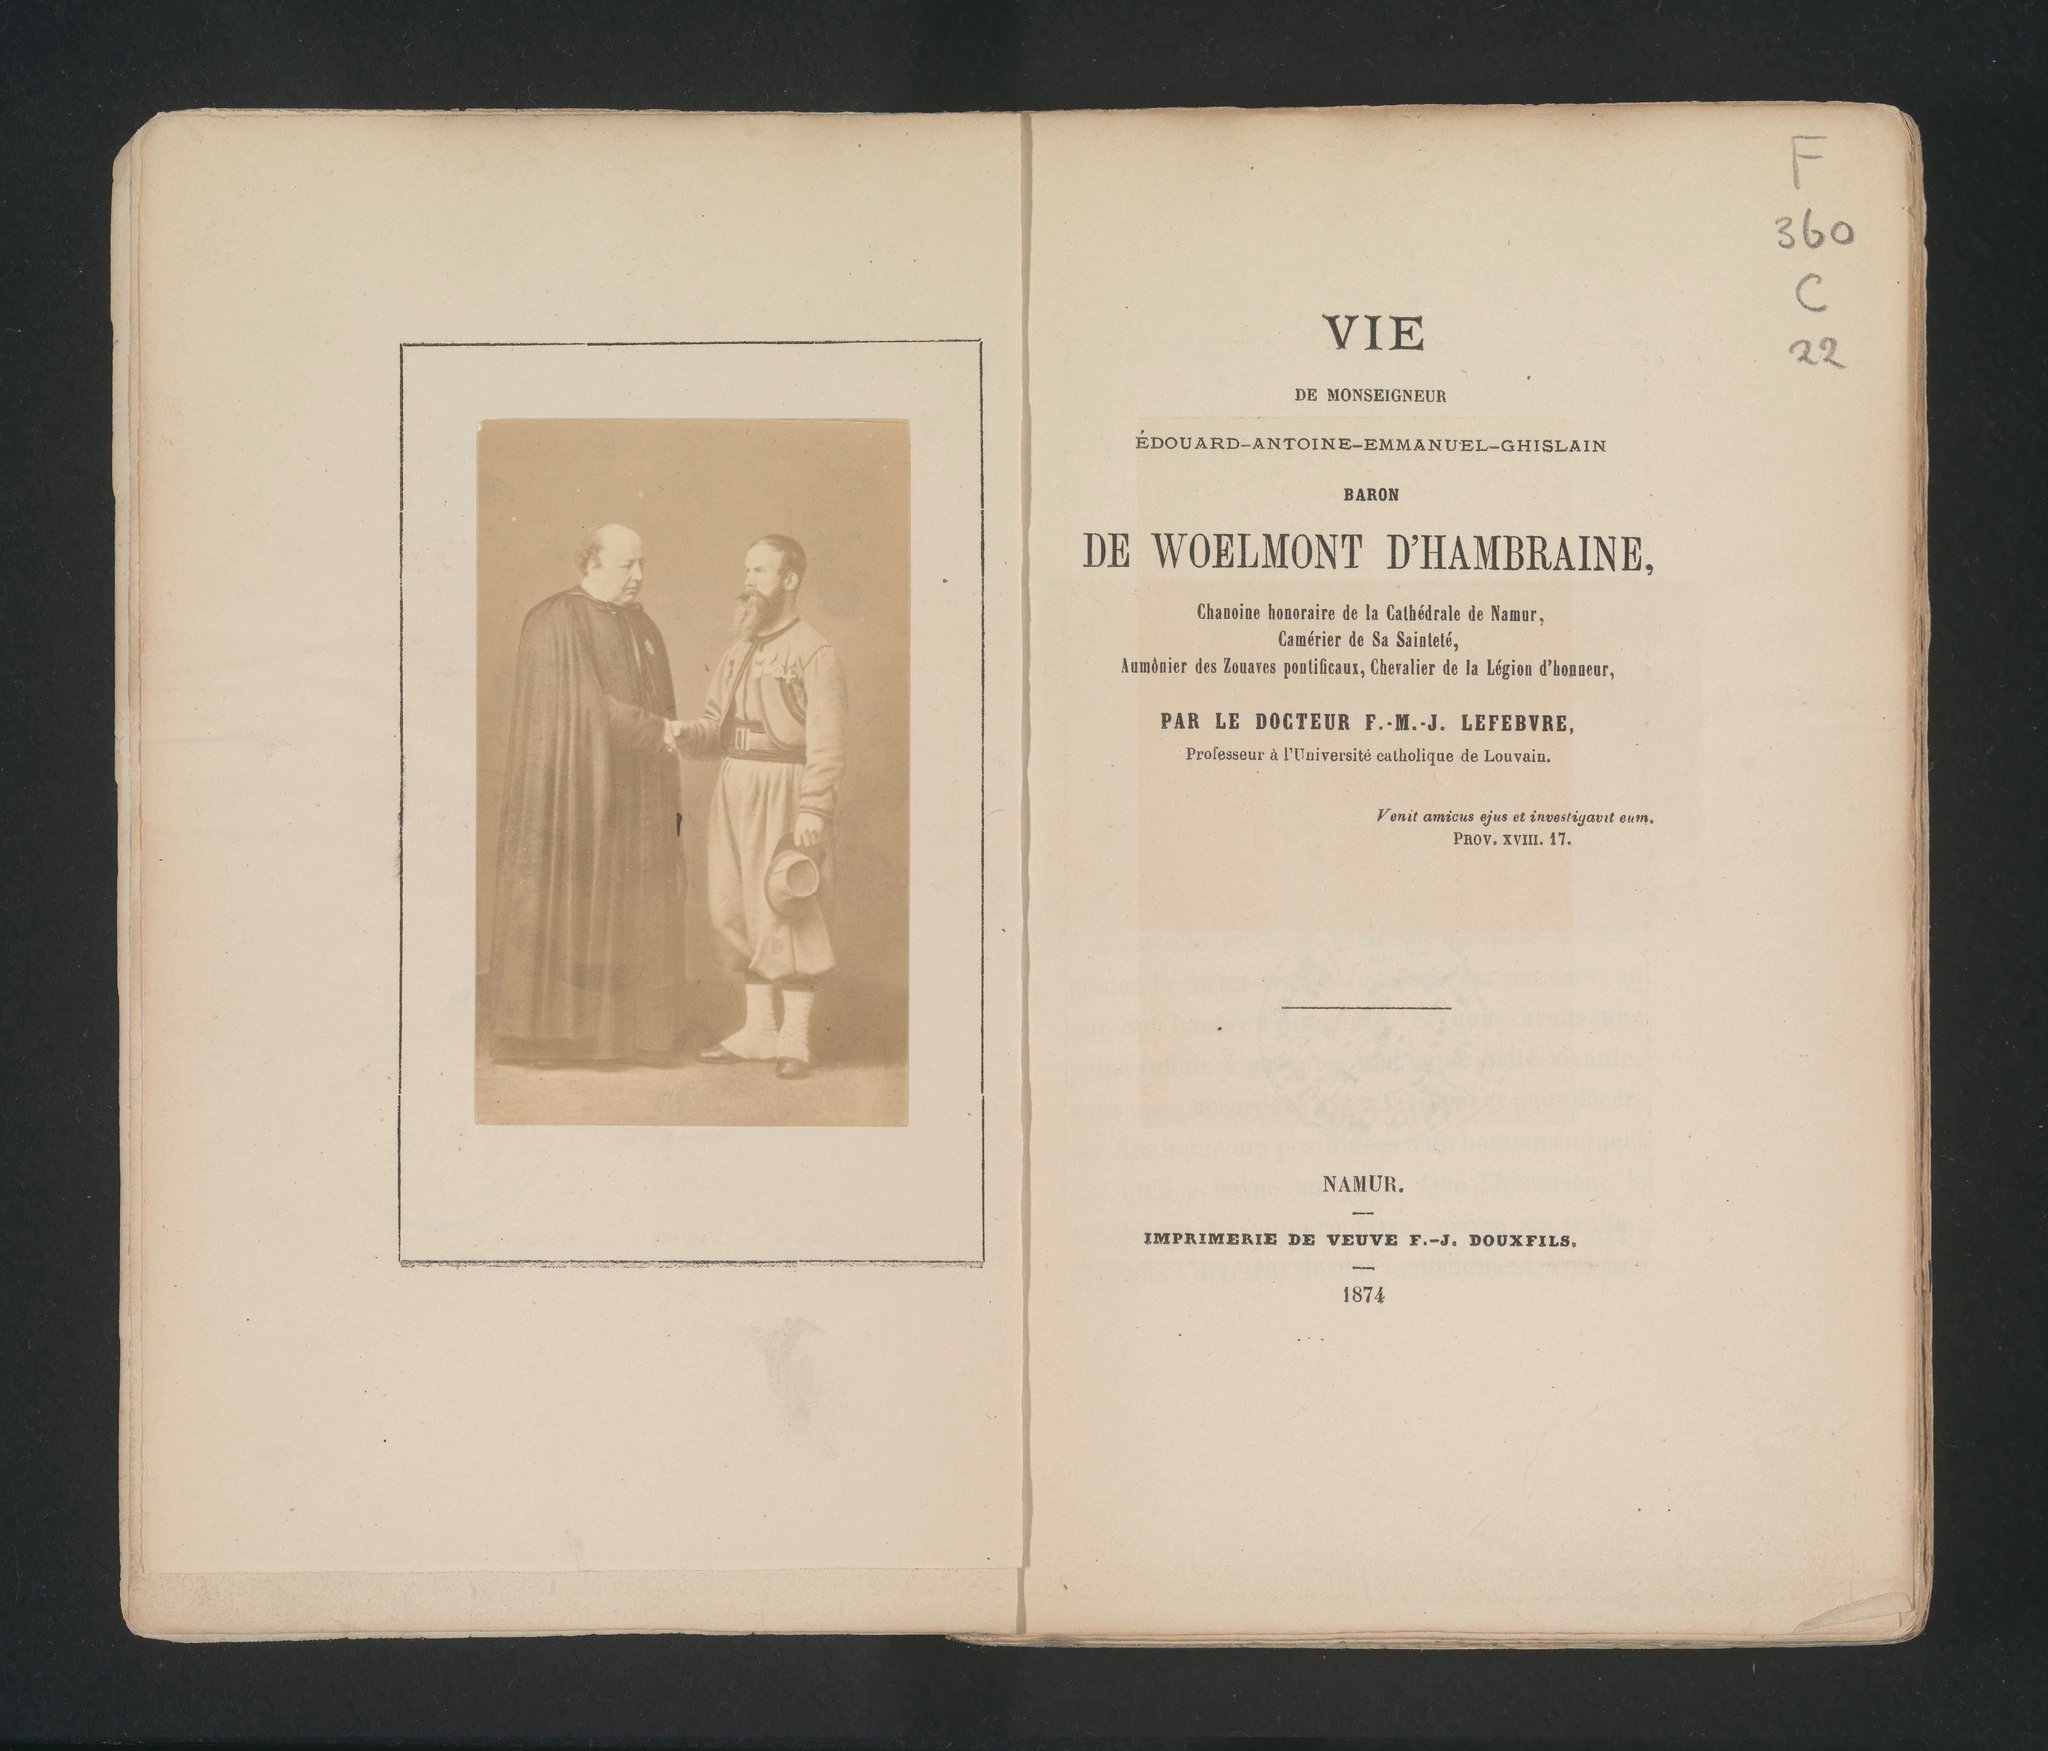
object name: photograph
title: Bisschop Edouard Woelmont schudt de hand van een soldaat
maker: Anonymous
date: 1869-1874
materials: photographic support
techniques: albumen print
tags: archbishop, bishop, etc. (roman catholic), private soldier, historical persons